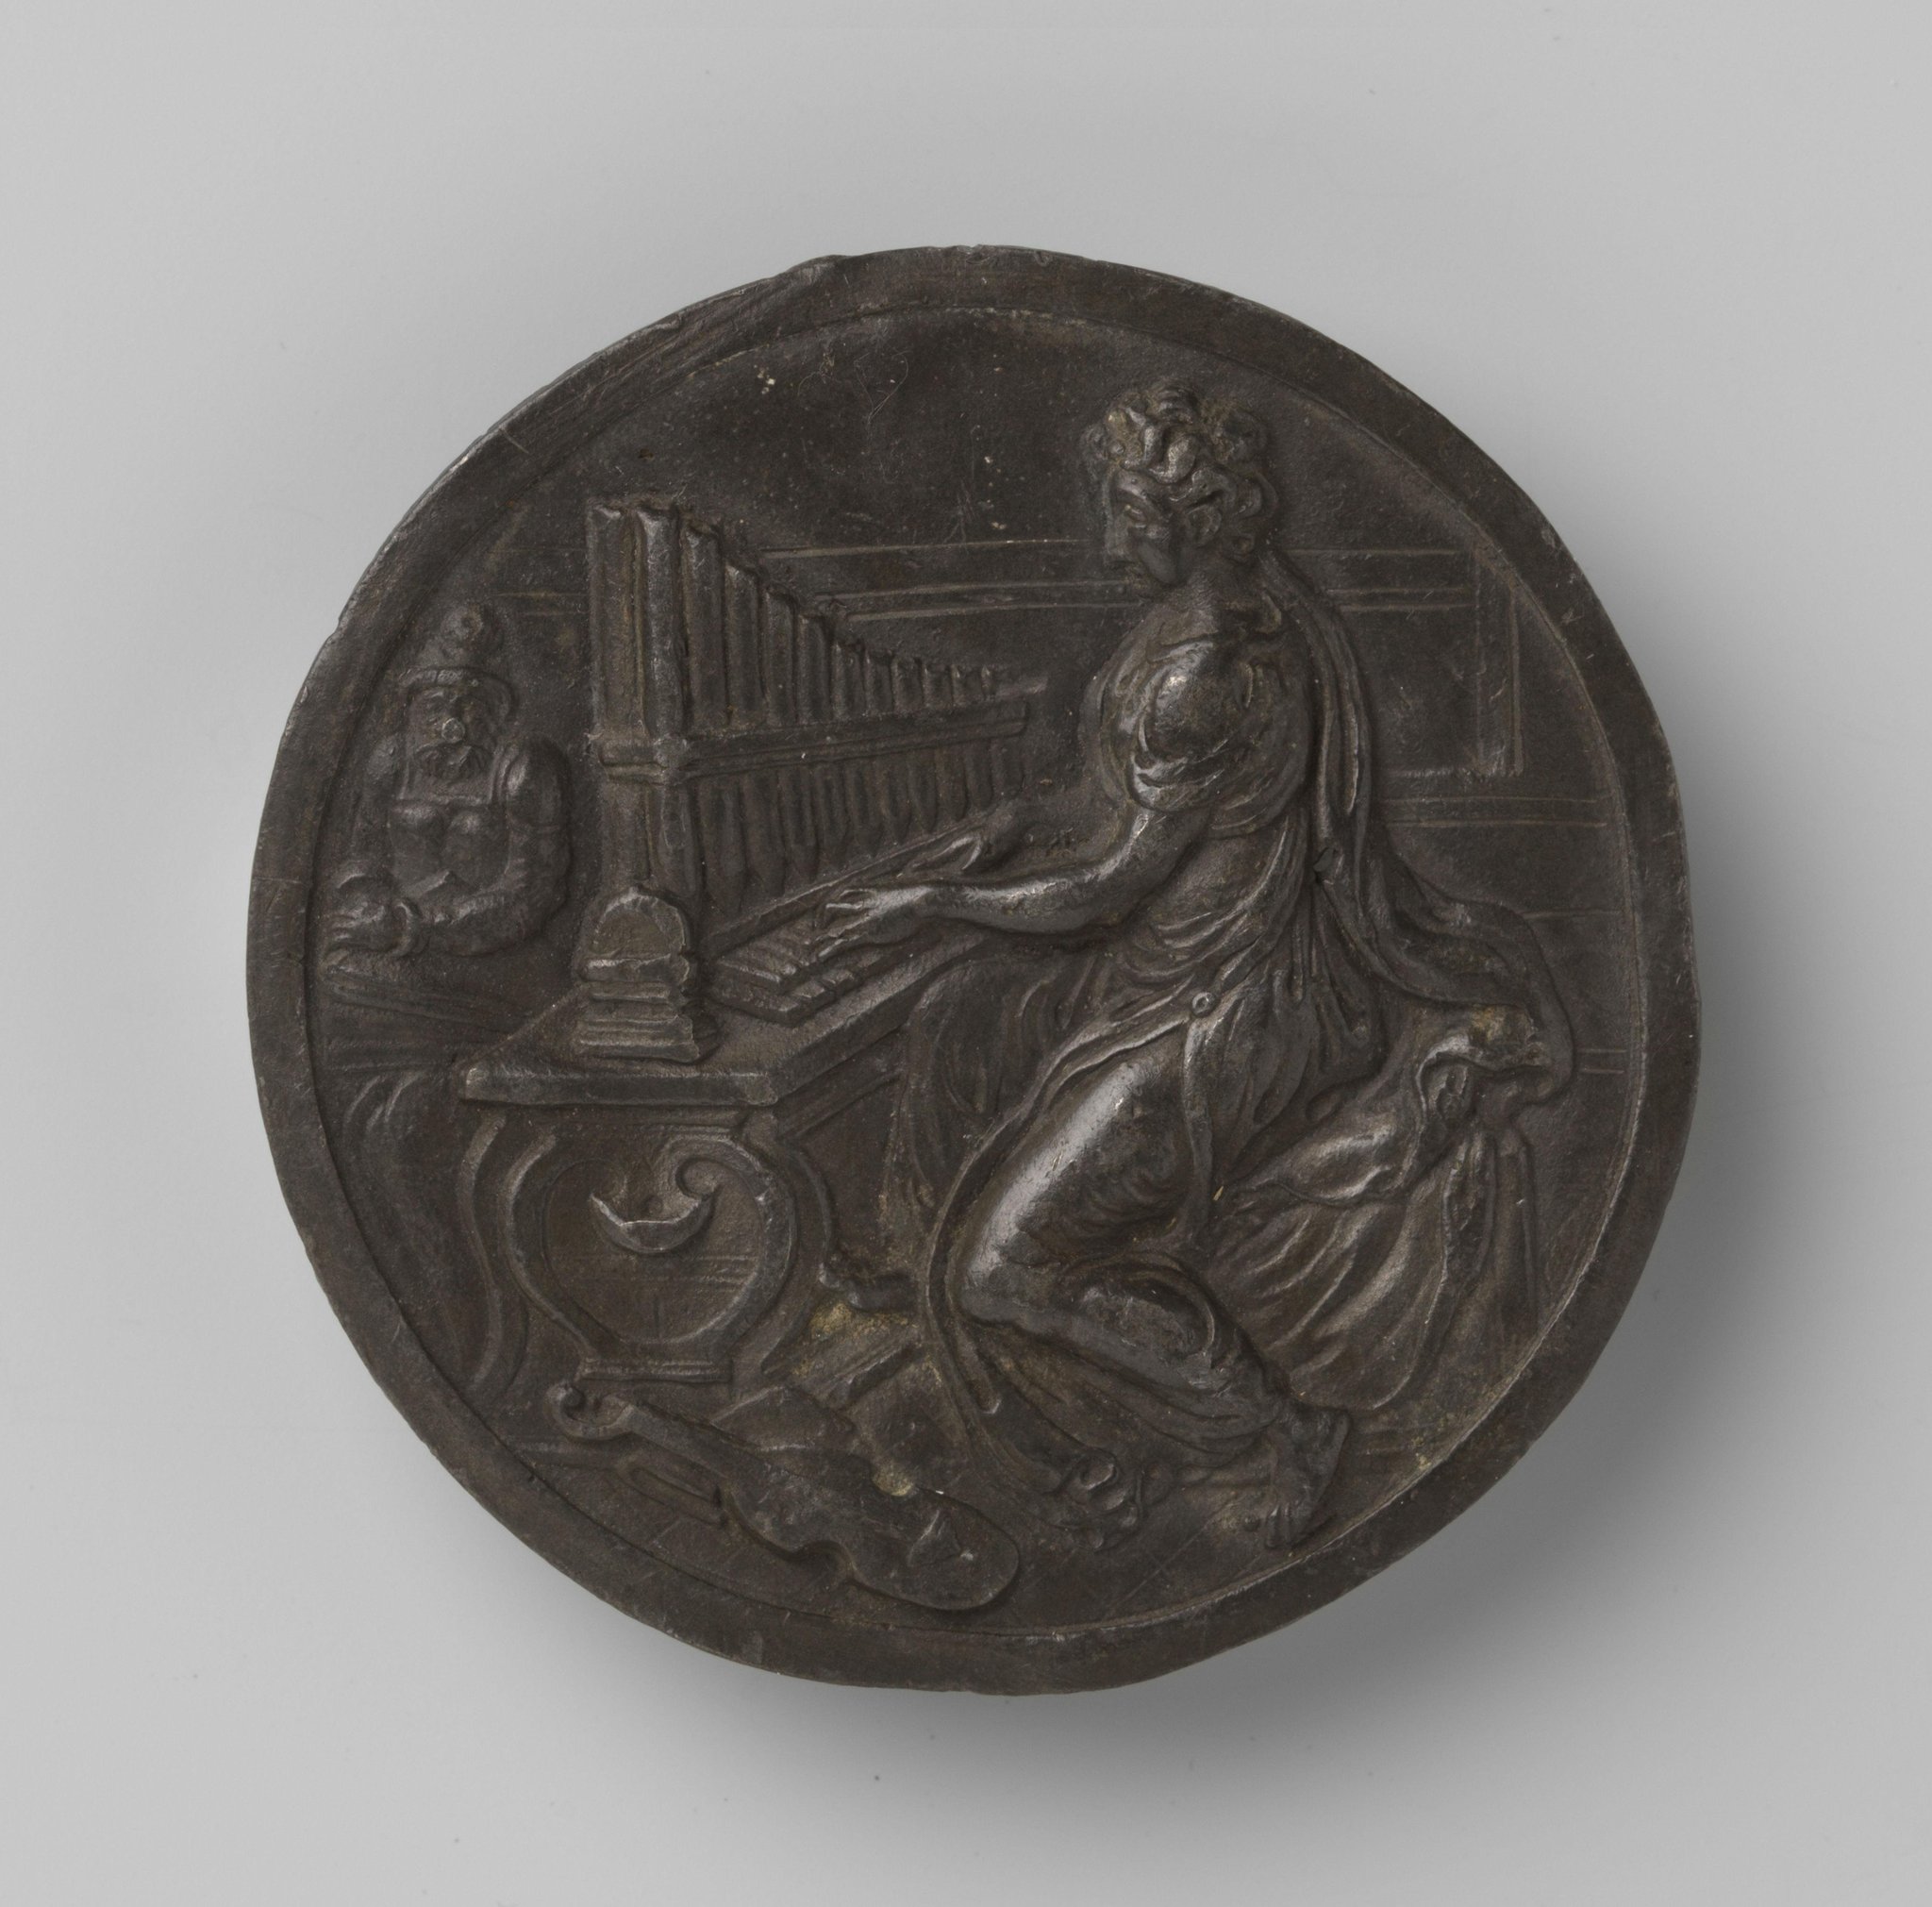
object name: plaque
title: Plaquette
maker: Anonymous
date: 1600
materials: lead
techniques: casting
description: Plaquette, rond, van lood met een voorstelling van De heilige Cecilia voor een orgel, achter haar een man aan de blaasbalg.